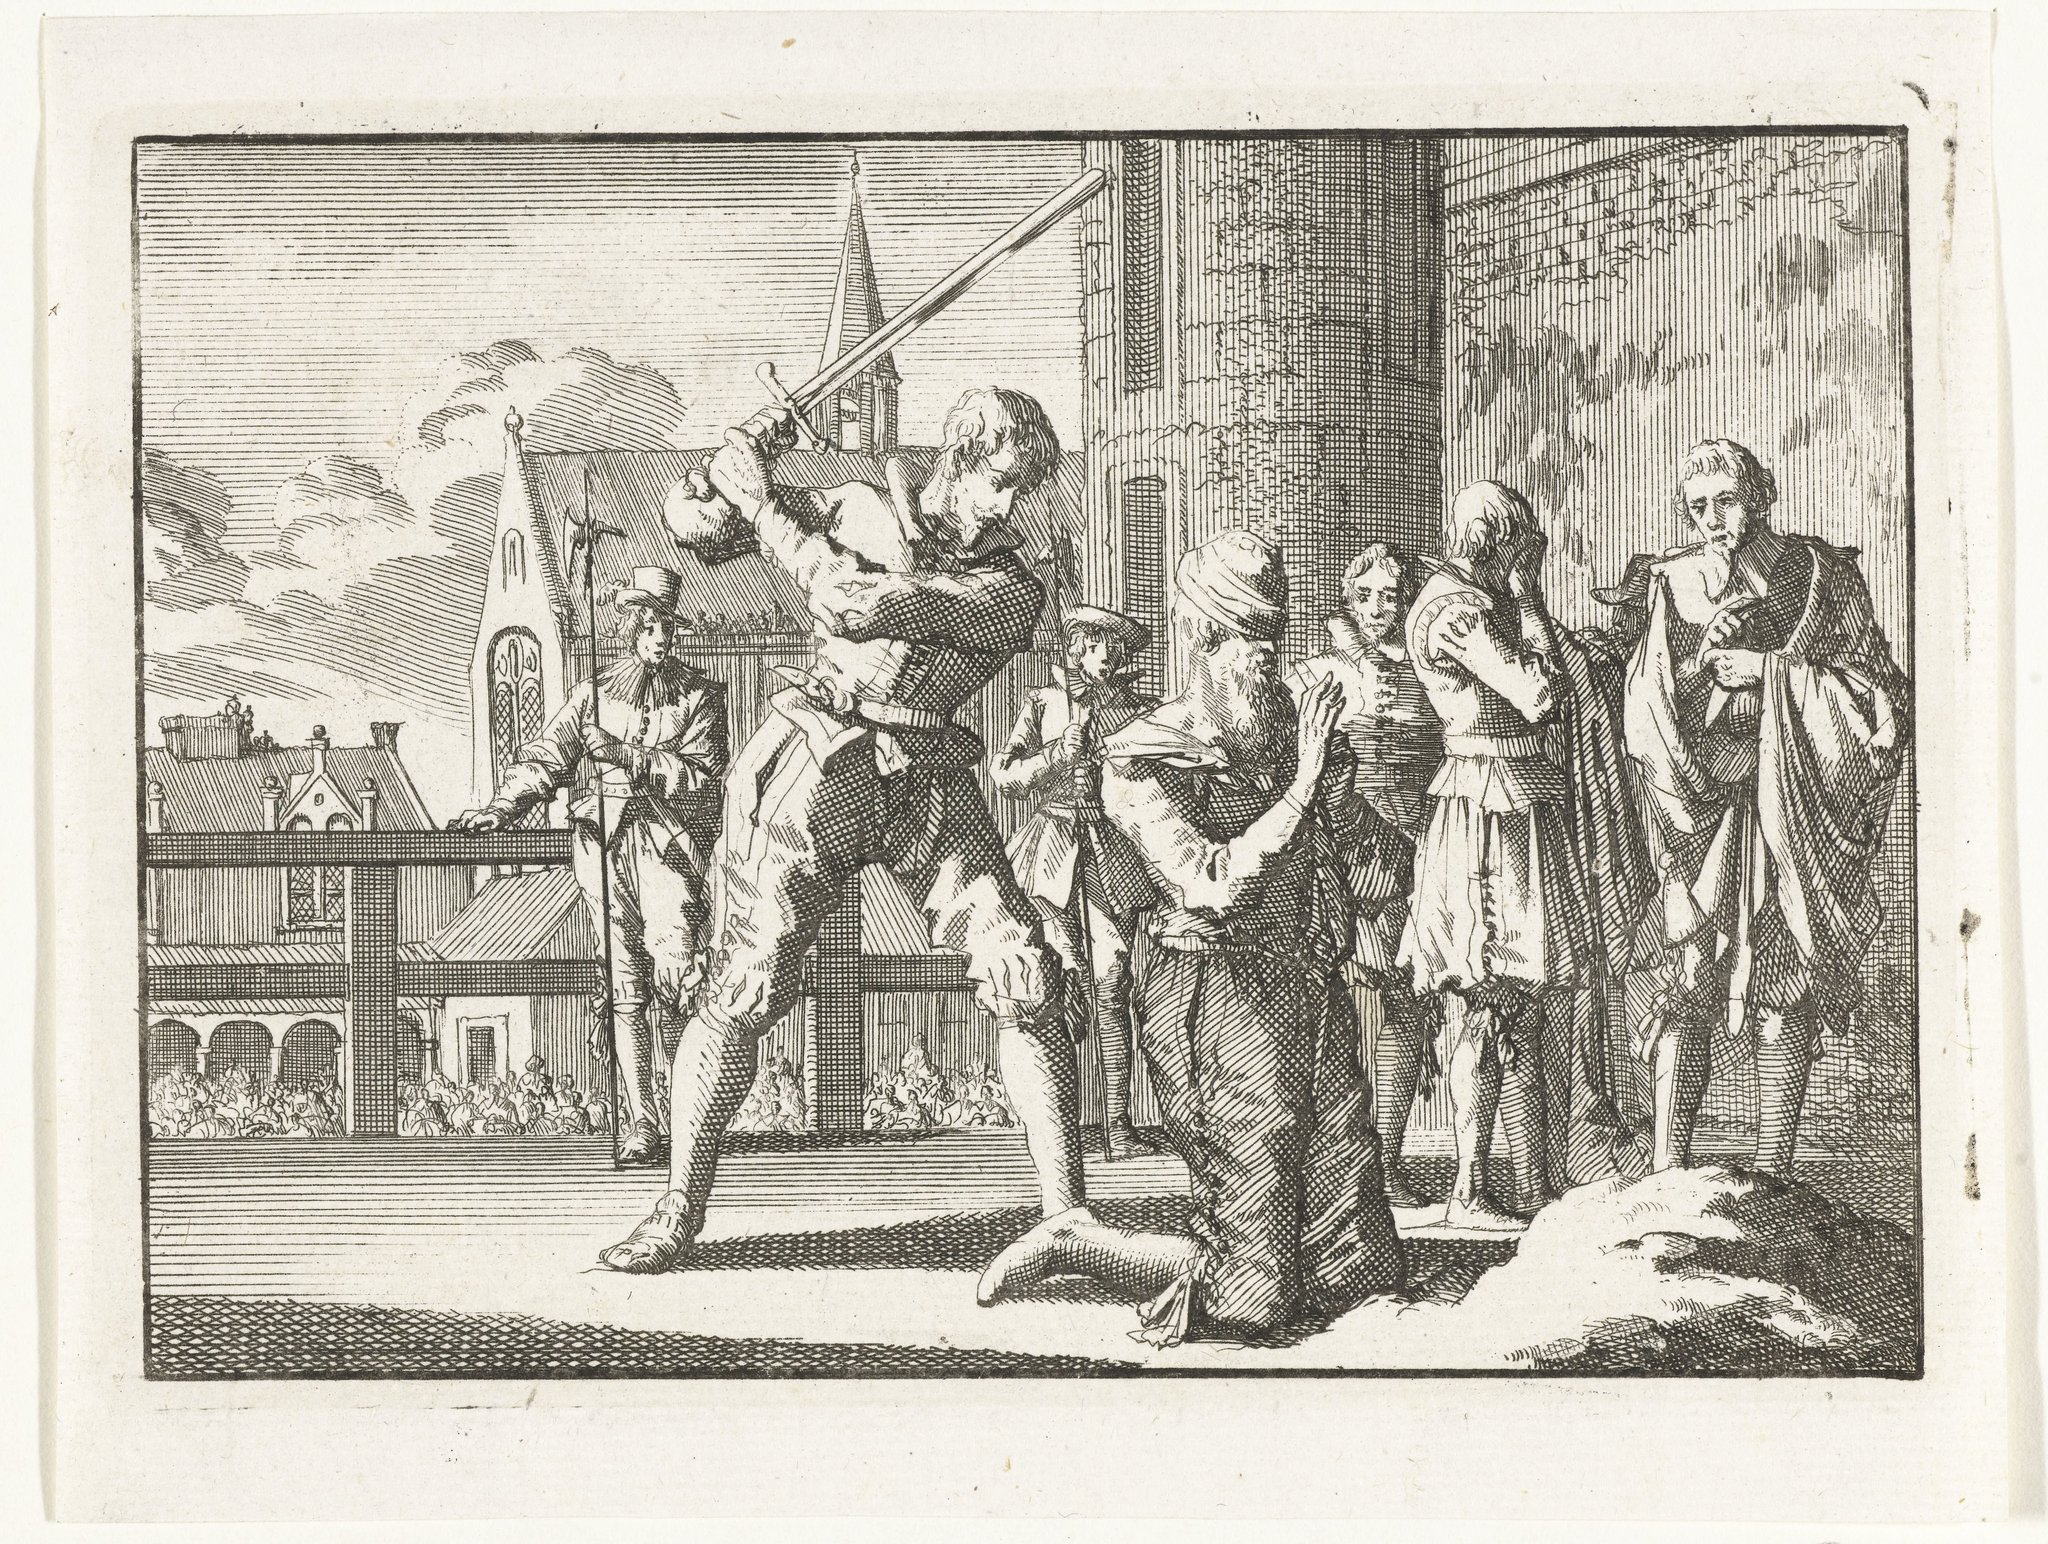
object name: history print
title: Onthoofding van Johan van Oldenbarnevelt, 1619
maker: jan luyken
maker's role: draughtsman, print maker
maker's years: 1649-1712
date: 1696-1700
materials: paper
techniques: etching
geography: northern netherlands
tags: johan van oldenbarnevelt, the hague, maurice (prince of orange), on the scaffold or place of execution, violent death by beheading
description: Johan van Oldenbarnevelt knielt geblinddoekt voor zijn onthoofding op het schavot op het Binnenhof te 's-Gravenhage op 13 mei 1619. Gezicht op het schavot, de knecht Jan Francken staat afgewend met handen voor het gelaat.